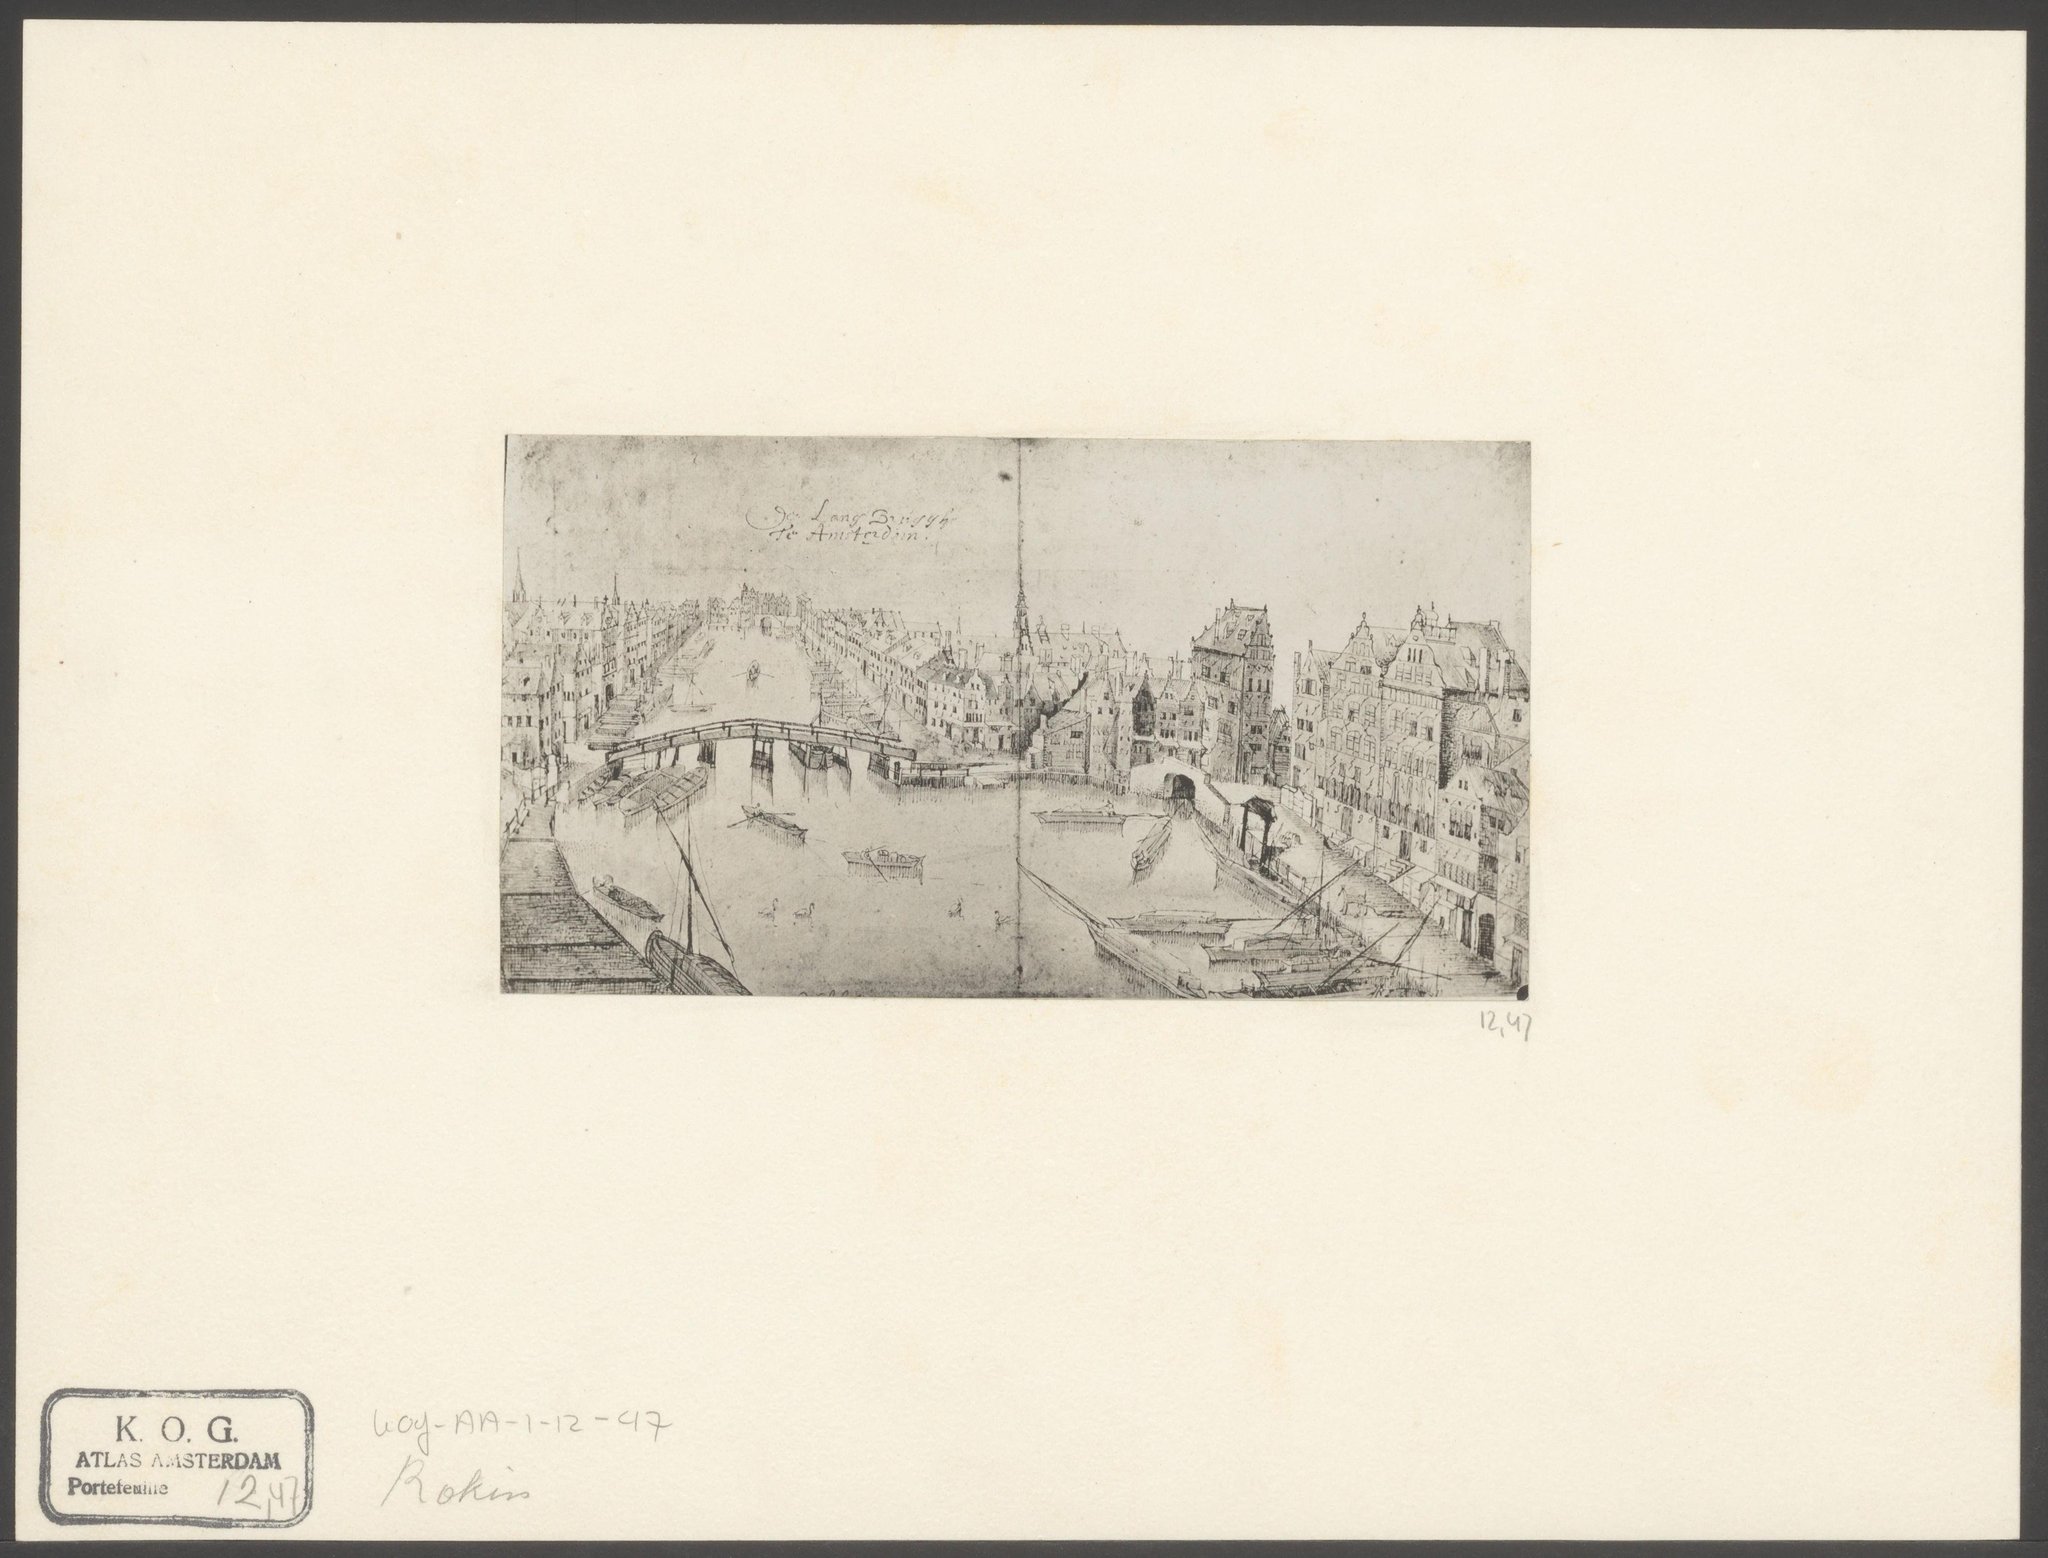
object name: photograph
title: Gezicht op het Rokin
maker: Anonymous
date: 1882-1950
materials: paper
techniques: gelatin silver print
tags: city-view in general; 'veduta', canal, bridge in city across river, canal, etc.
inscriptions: collector's mark: ‘12,47’ Lugt 1641b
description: Onderwerpsrubriek binnen de Atlas Amsterdam: Rokin, Rotterdammersloot, Rozengang, Rozengracht, Rozenstraat, Rusland, Rustenburgerstraat, Ruysdaelkade, Ruysdaelstraat, Ruyterkade (de), Ruyterweg (Admiraal de).